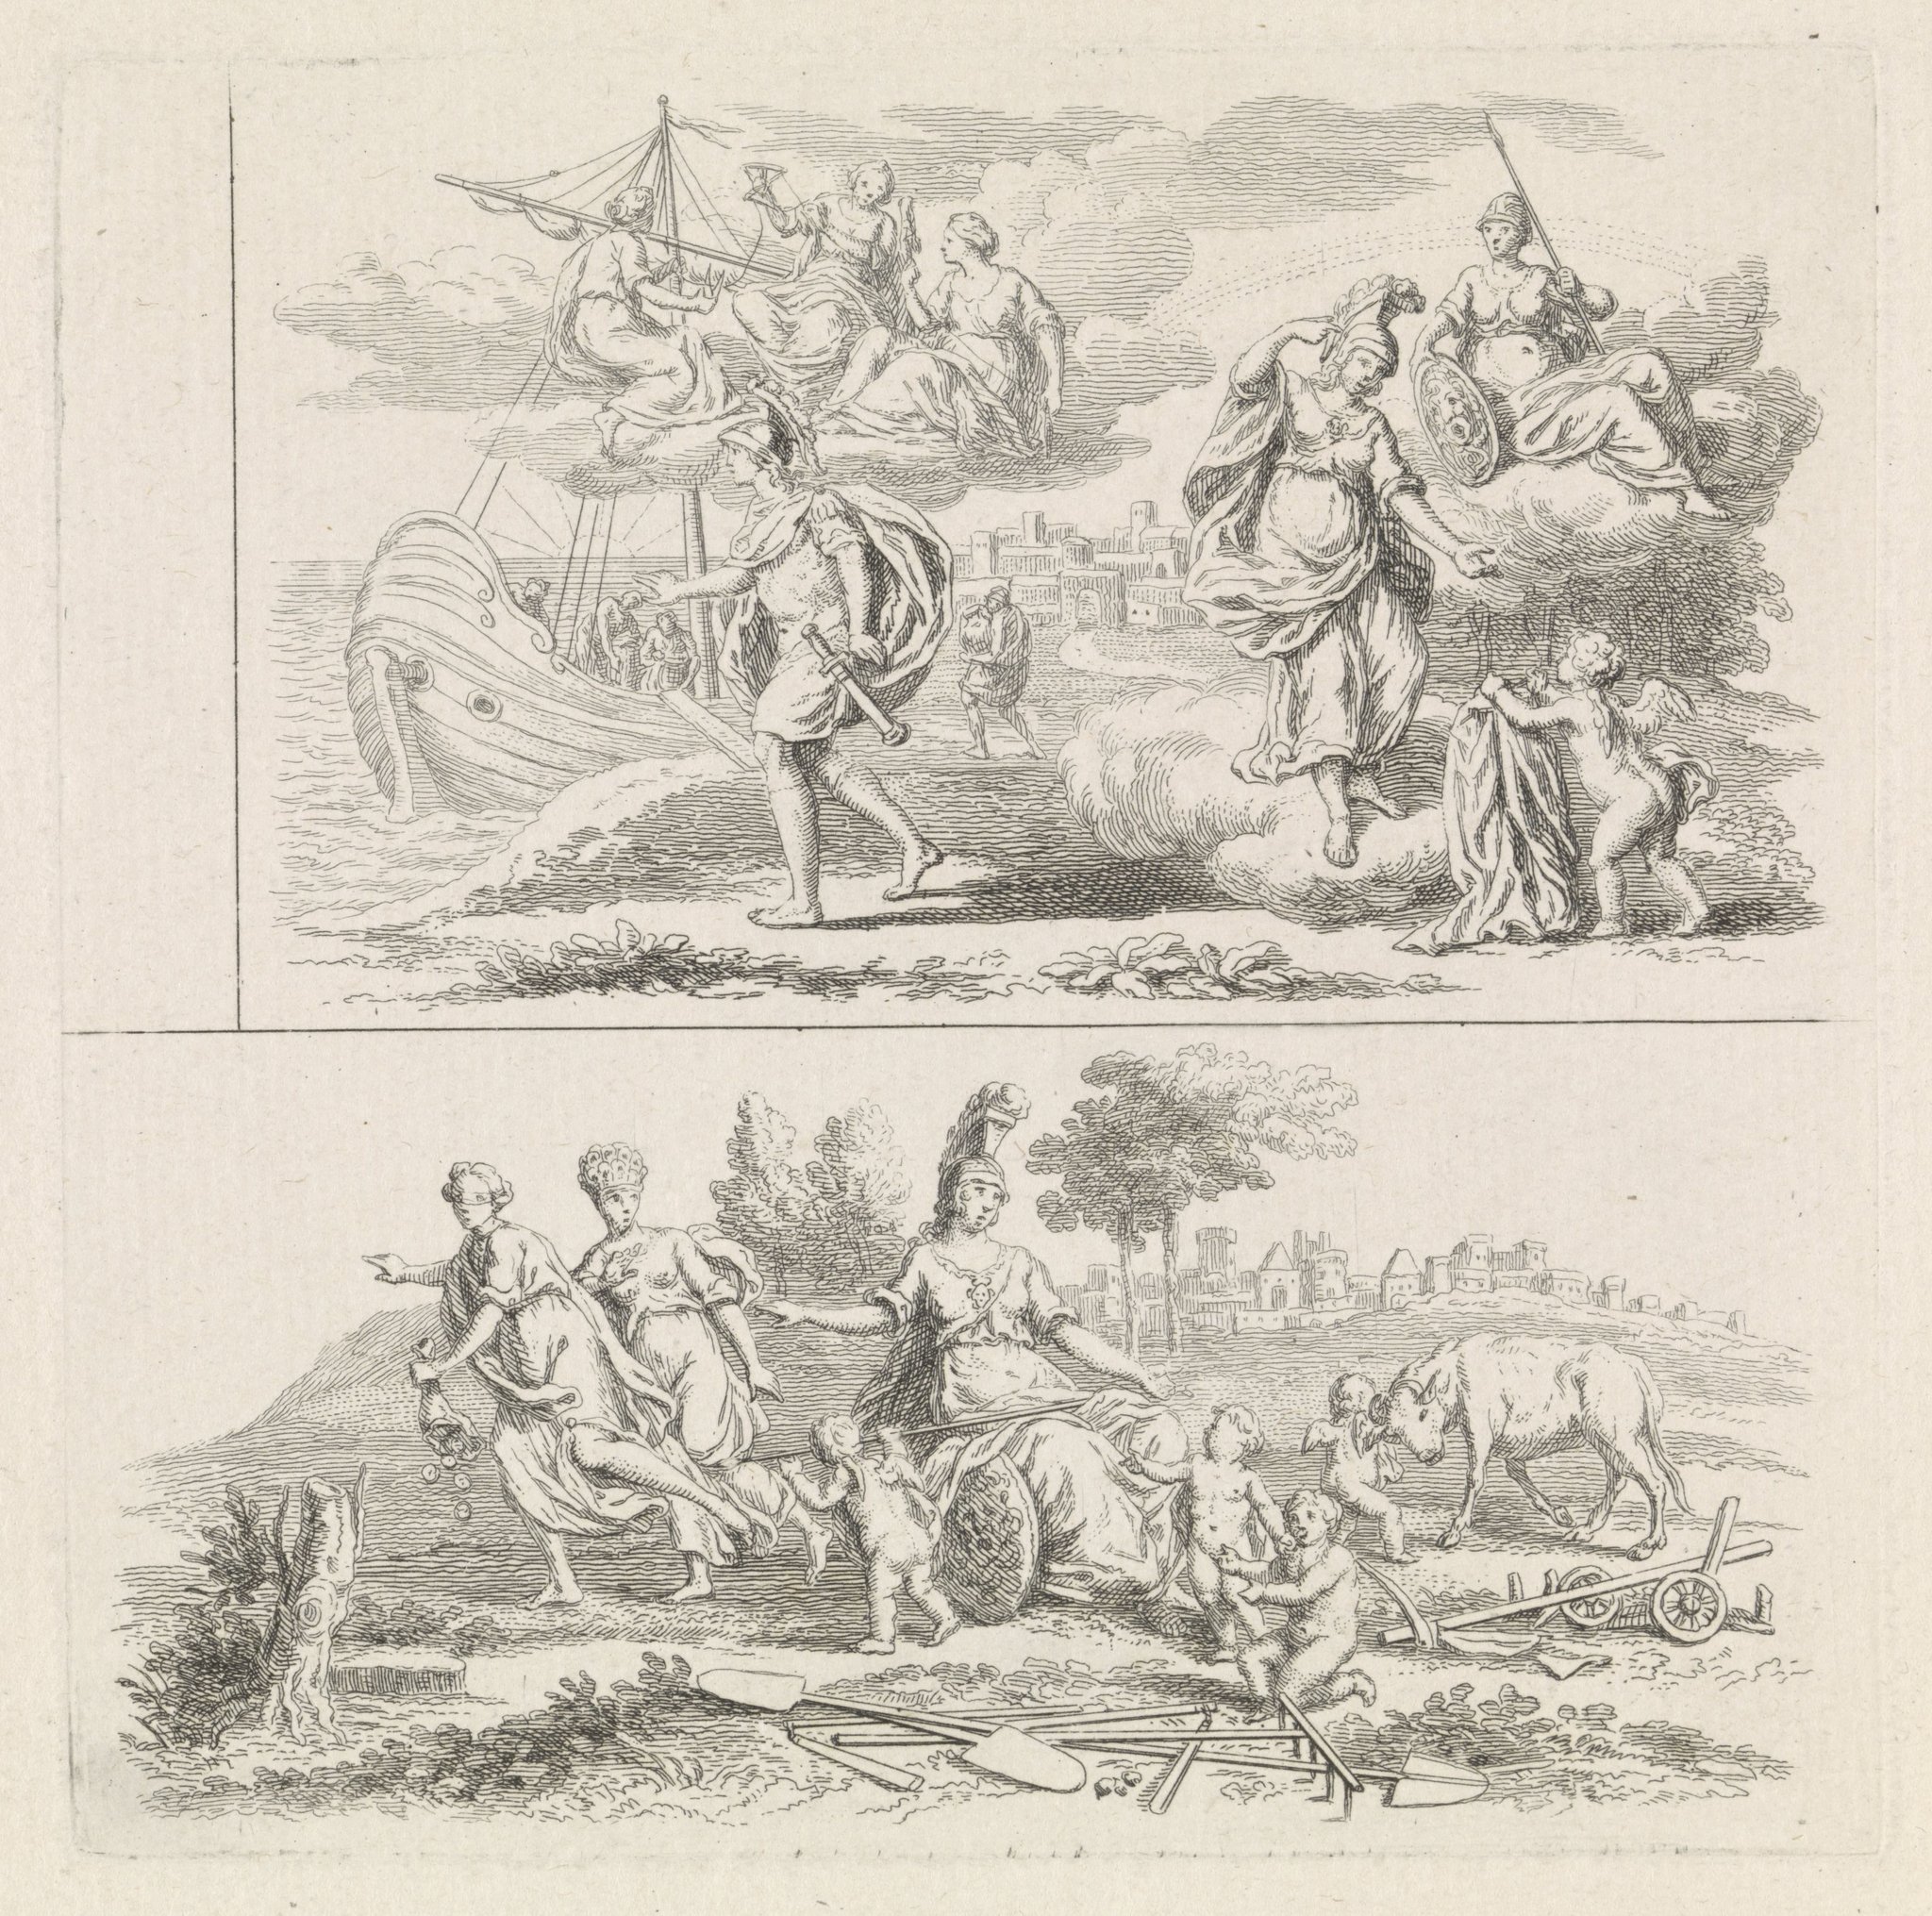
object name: print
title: Twee voorstellingen met Minerva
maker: pieter tanjé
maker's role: draughtsman, print maker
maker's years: 1706-1761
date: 1716-1761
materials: paper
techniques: etching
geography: amsterdam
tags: sailing-ship, sailing-boat, (story of) minerva (pallas, athena), luck, fortune, lot; 'fato', 'fortuna', 'fortuna aurea', 'fortuna buona', 'fortuna pacifica overo clemente', 'sorte' (ripa)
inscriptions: collector's mark: Lugt 240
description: Op de bovenste voorstelling daalt Minerva van een wolk naar Amor, die een kledingstuk ophoudt. Links een held en een schip. Op de onderste voorstelling zit Minerva op een akker, waar verschillende putti om haar heen zitten. Ze wijst op Fortuna, die samen met een andere vrouw, wegloopt.